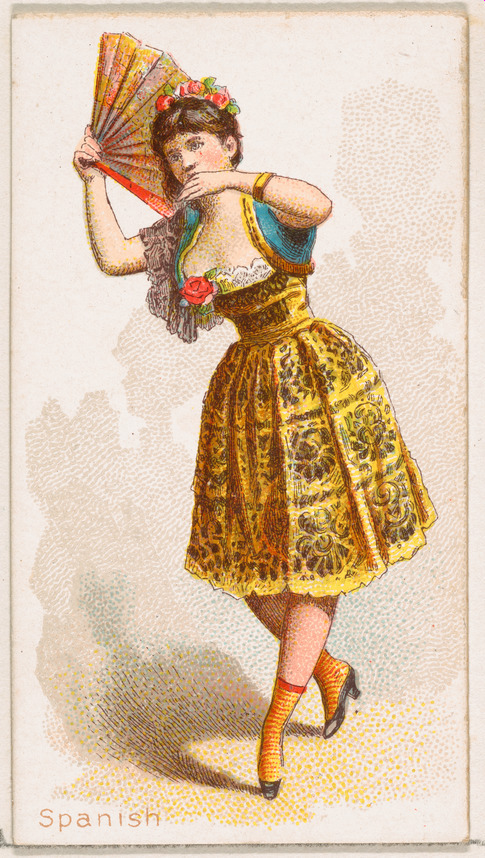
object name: print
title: Spanish Dancer, from the Dancing Women series (N186) issued by Wm. S. Kimball & Co.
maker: william s. kimball & company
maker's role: publisher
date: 1889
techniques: color lithograph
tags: women,dancers